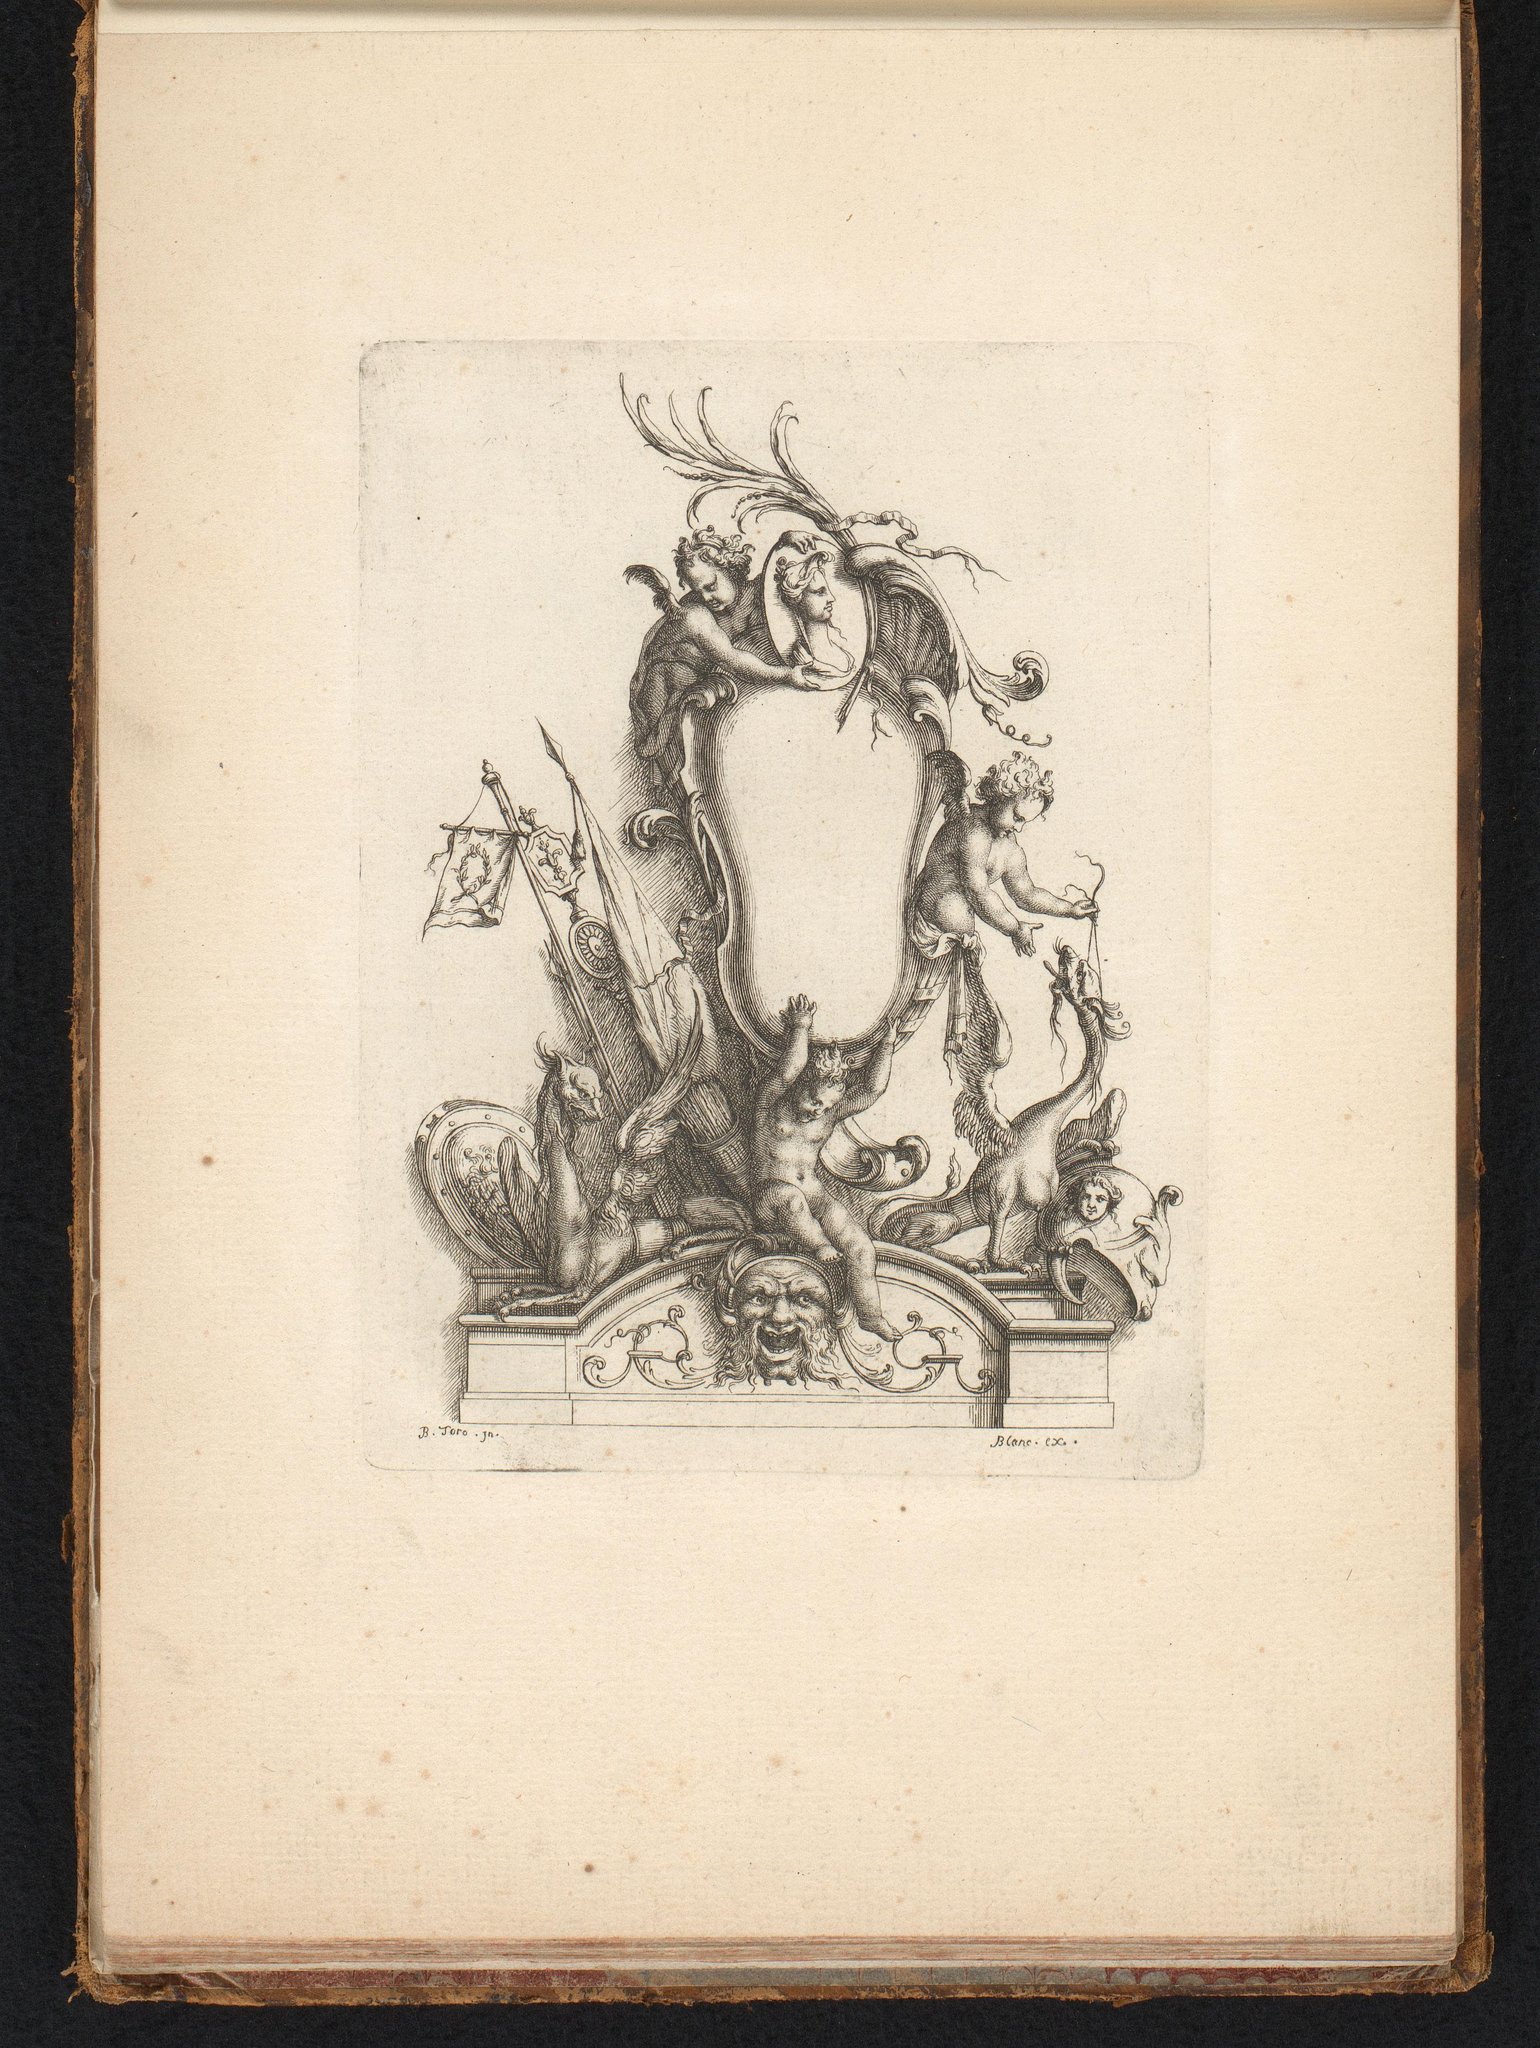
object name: album leaf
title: Ontwerpen voor cartouches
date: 1682-1729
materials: paper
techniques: engraving, etching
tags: ornament ~ cartouche, cupids: 'amores', 'amoretti', 'putti'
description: Prent maakt deel uit van een serie van zes prenten.